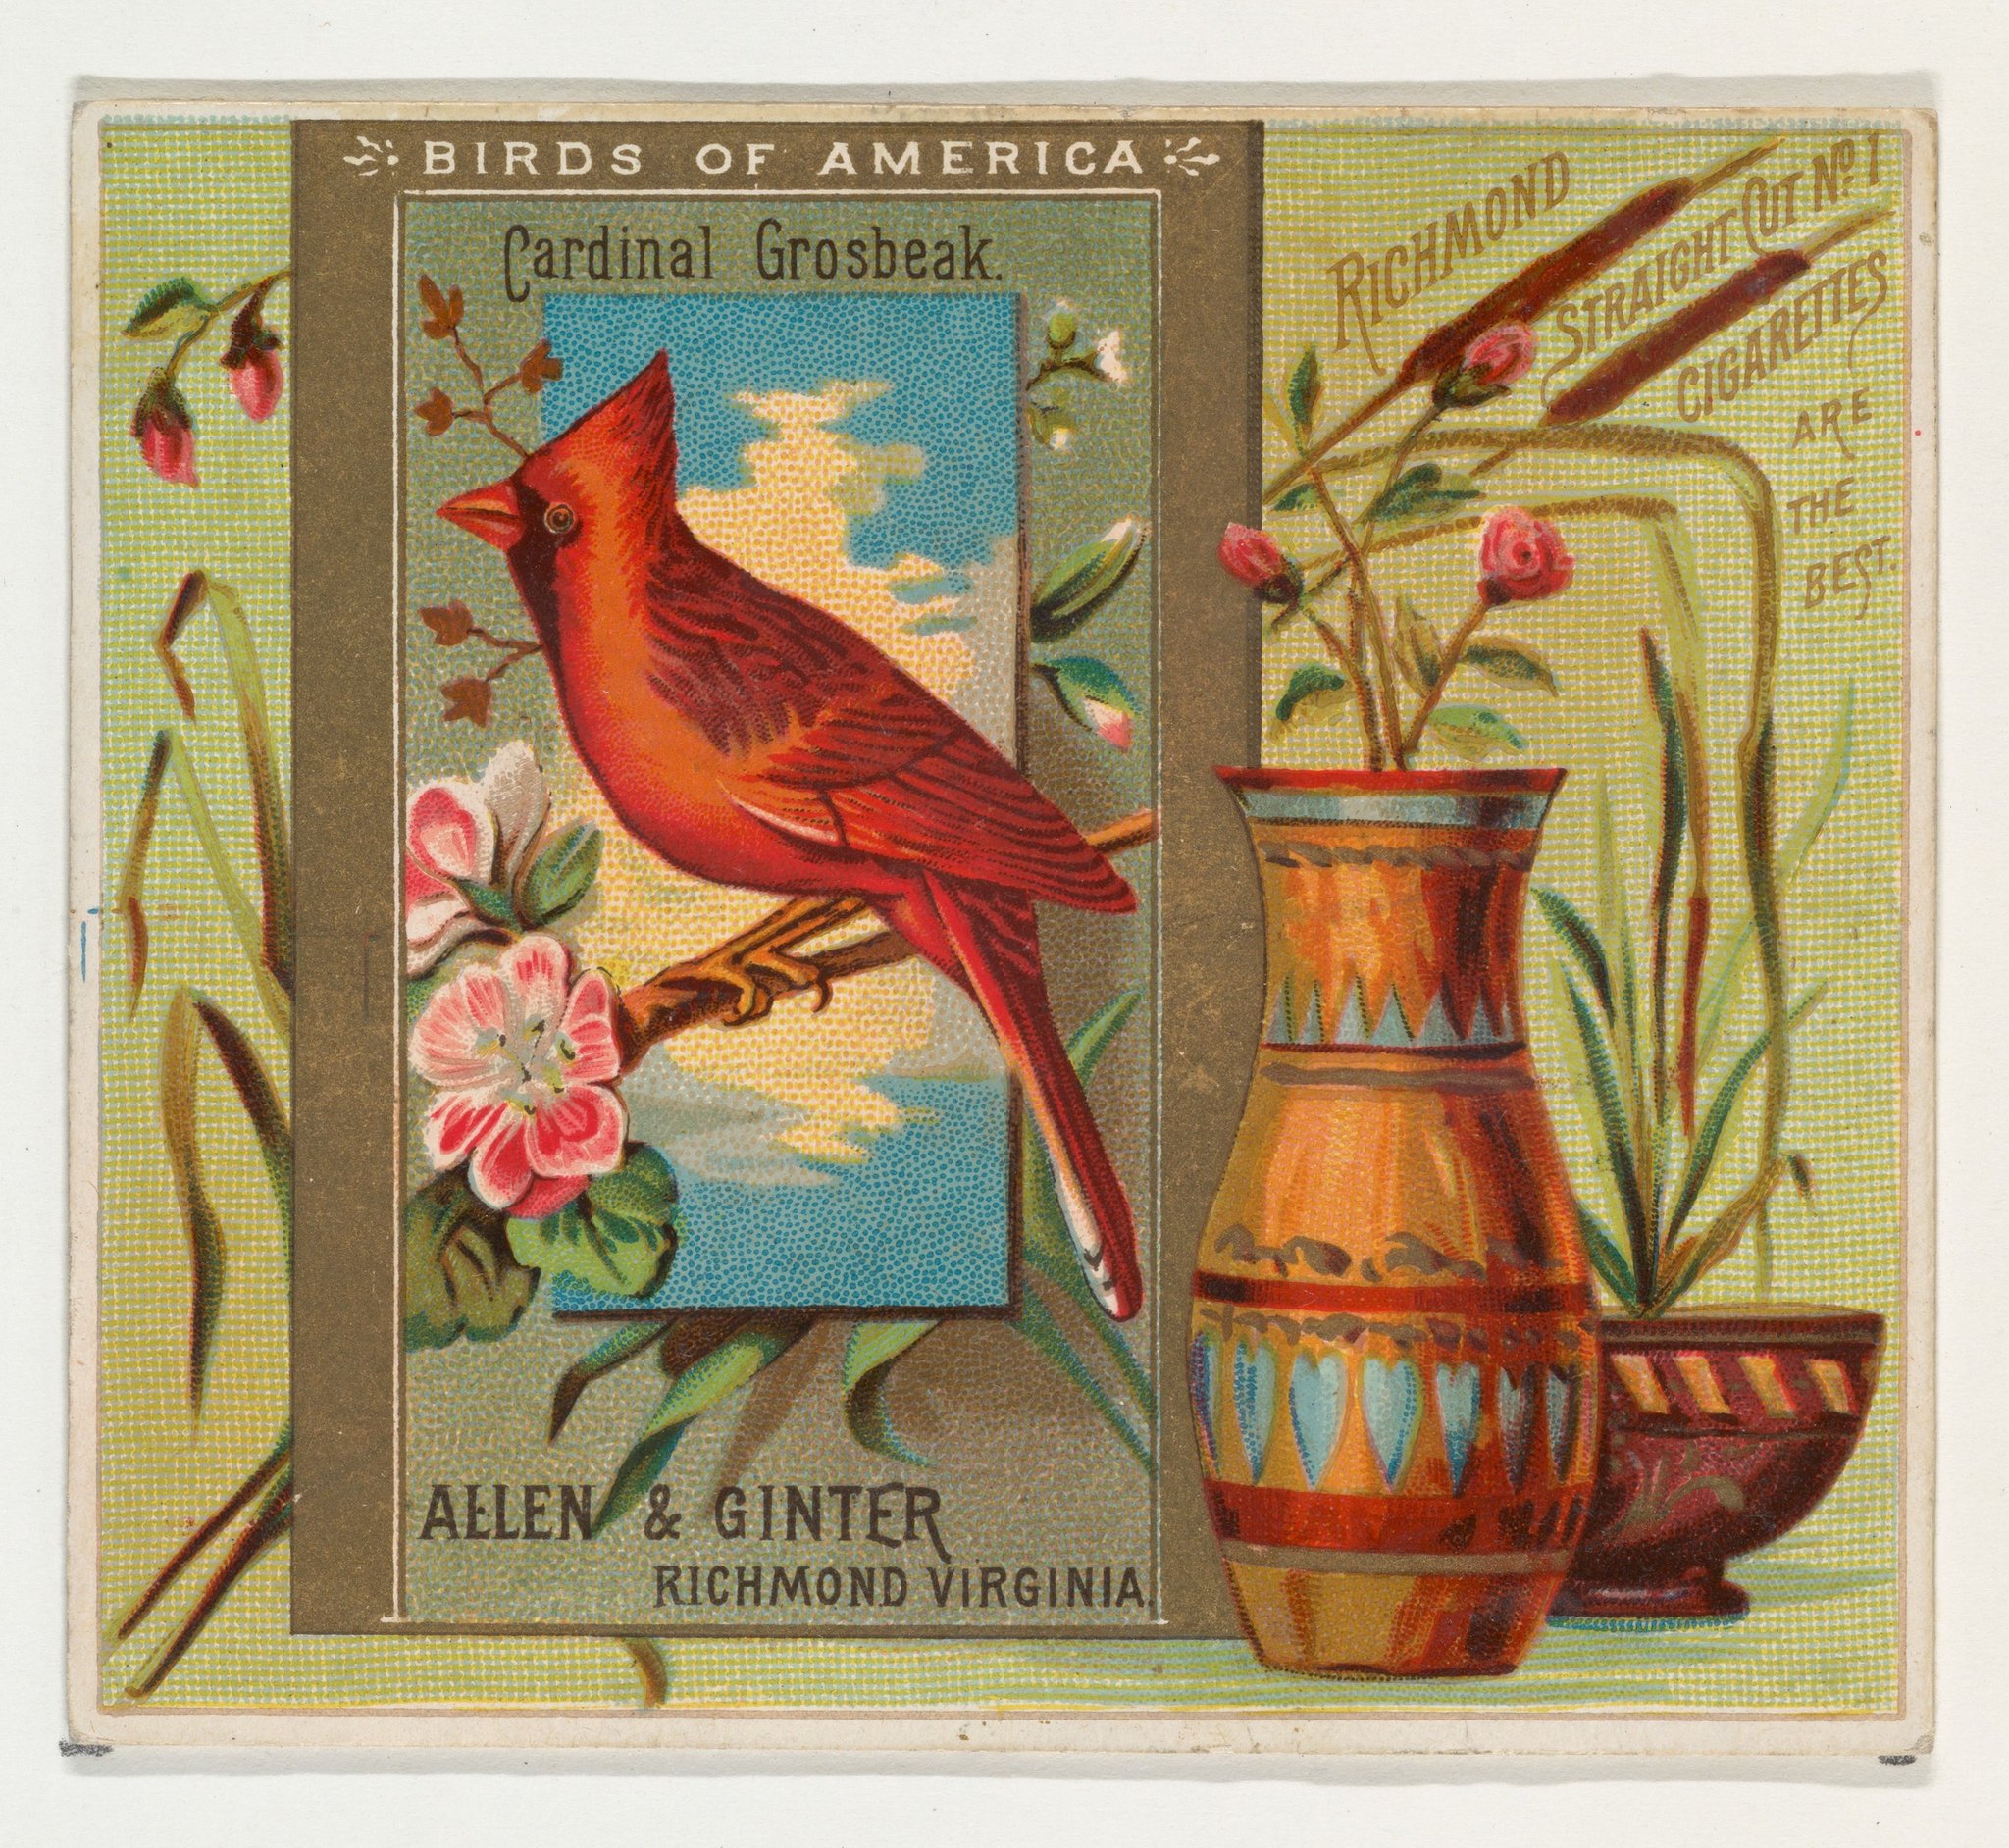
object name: print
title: Cardinal Grosbeak, from the Birds of America series (N37) for Allen & Ginter Cigarettes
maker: allen & ginter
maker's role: publisher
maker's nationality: american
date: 1888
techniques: color lithograph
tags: birds